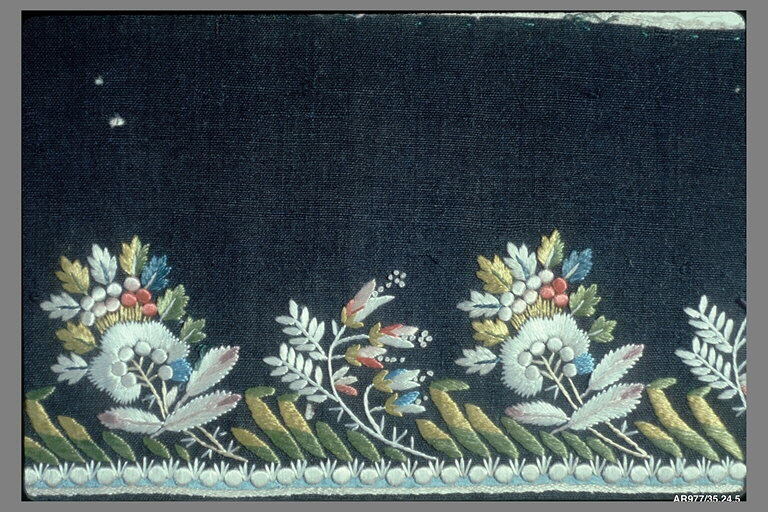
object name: sample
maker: jean françois bony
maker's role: designer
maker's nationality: french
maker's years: 1760-1825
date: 1767-1833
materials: silk, thread, wool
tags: flowers